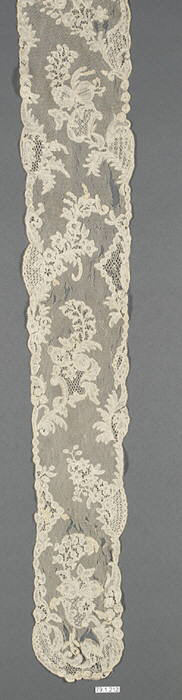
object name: lappet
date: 1726-1750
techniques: lace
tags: flowers